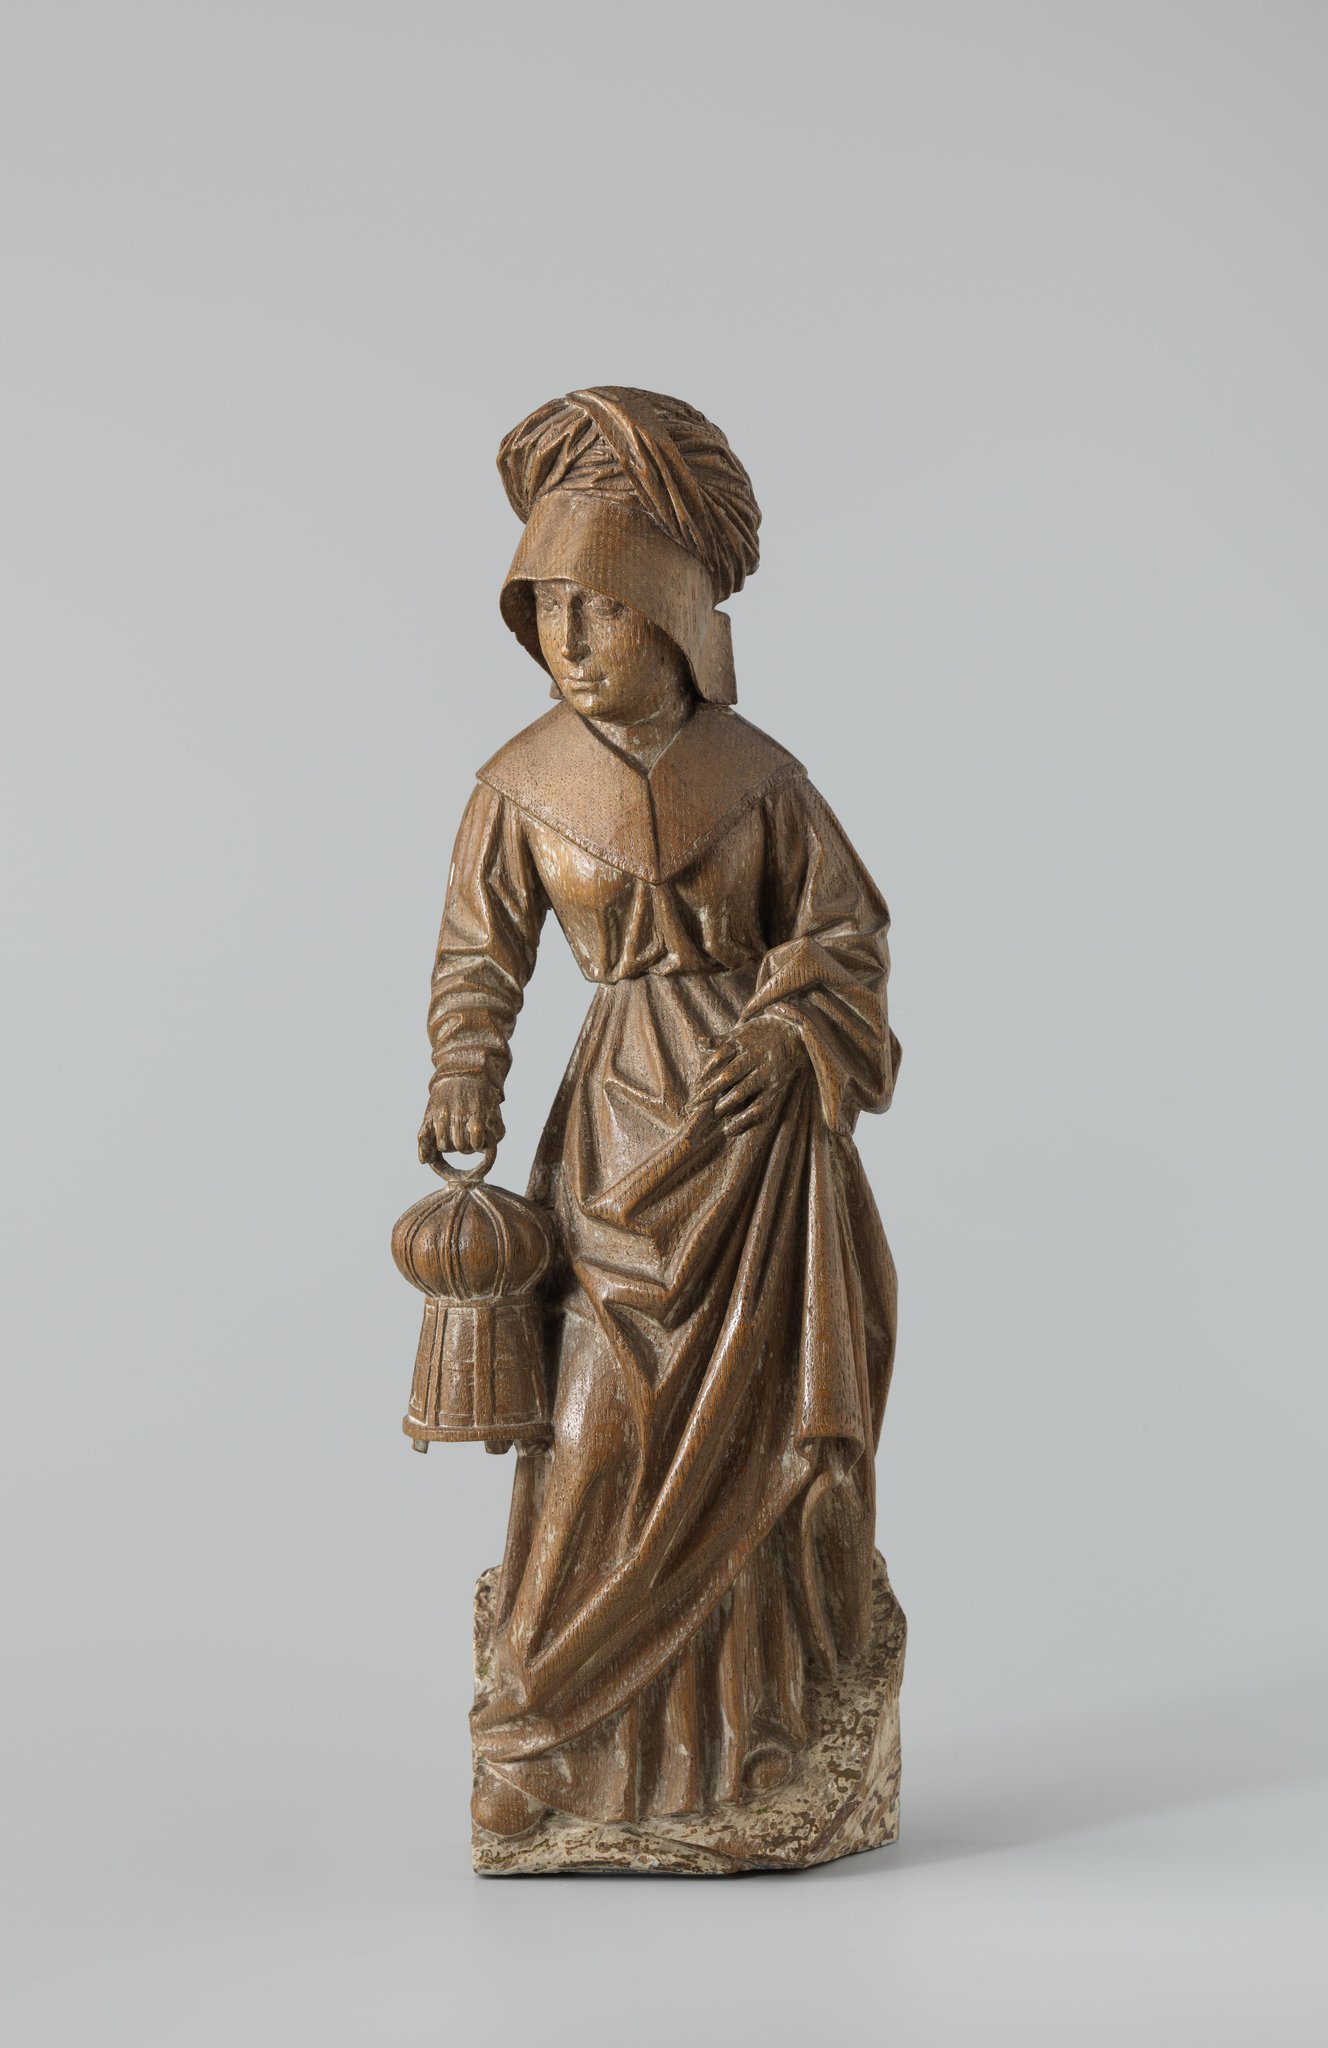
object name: sculpture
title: Woman with Lantern (Midwife or Persian Sibyl), from a Nativity or Adoration of the Shepherds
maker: Anonymous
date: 1500-1515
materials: wood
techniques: polychromy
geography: antwerp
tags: story of the birth of christ (luke 2:1-20)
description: Female saint with lantern. Oak with traces of polychromy. .Antwerp, c. 1500 - 1525.